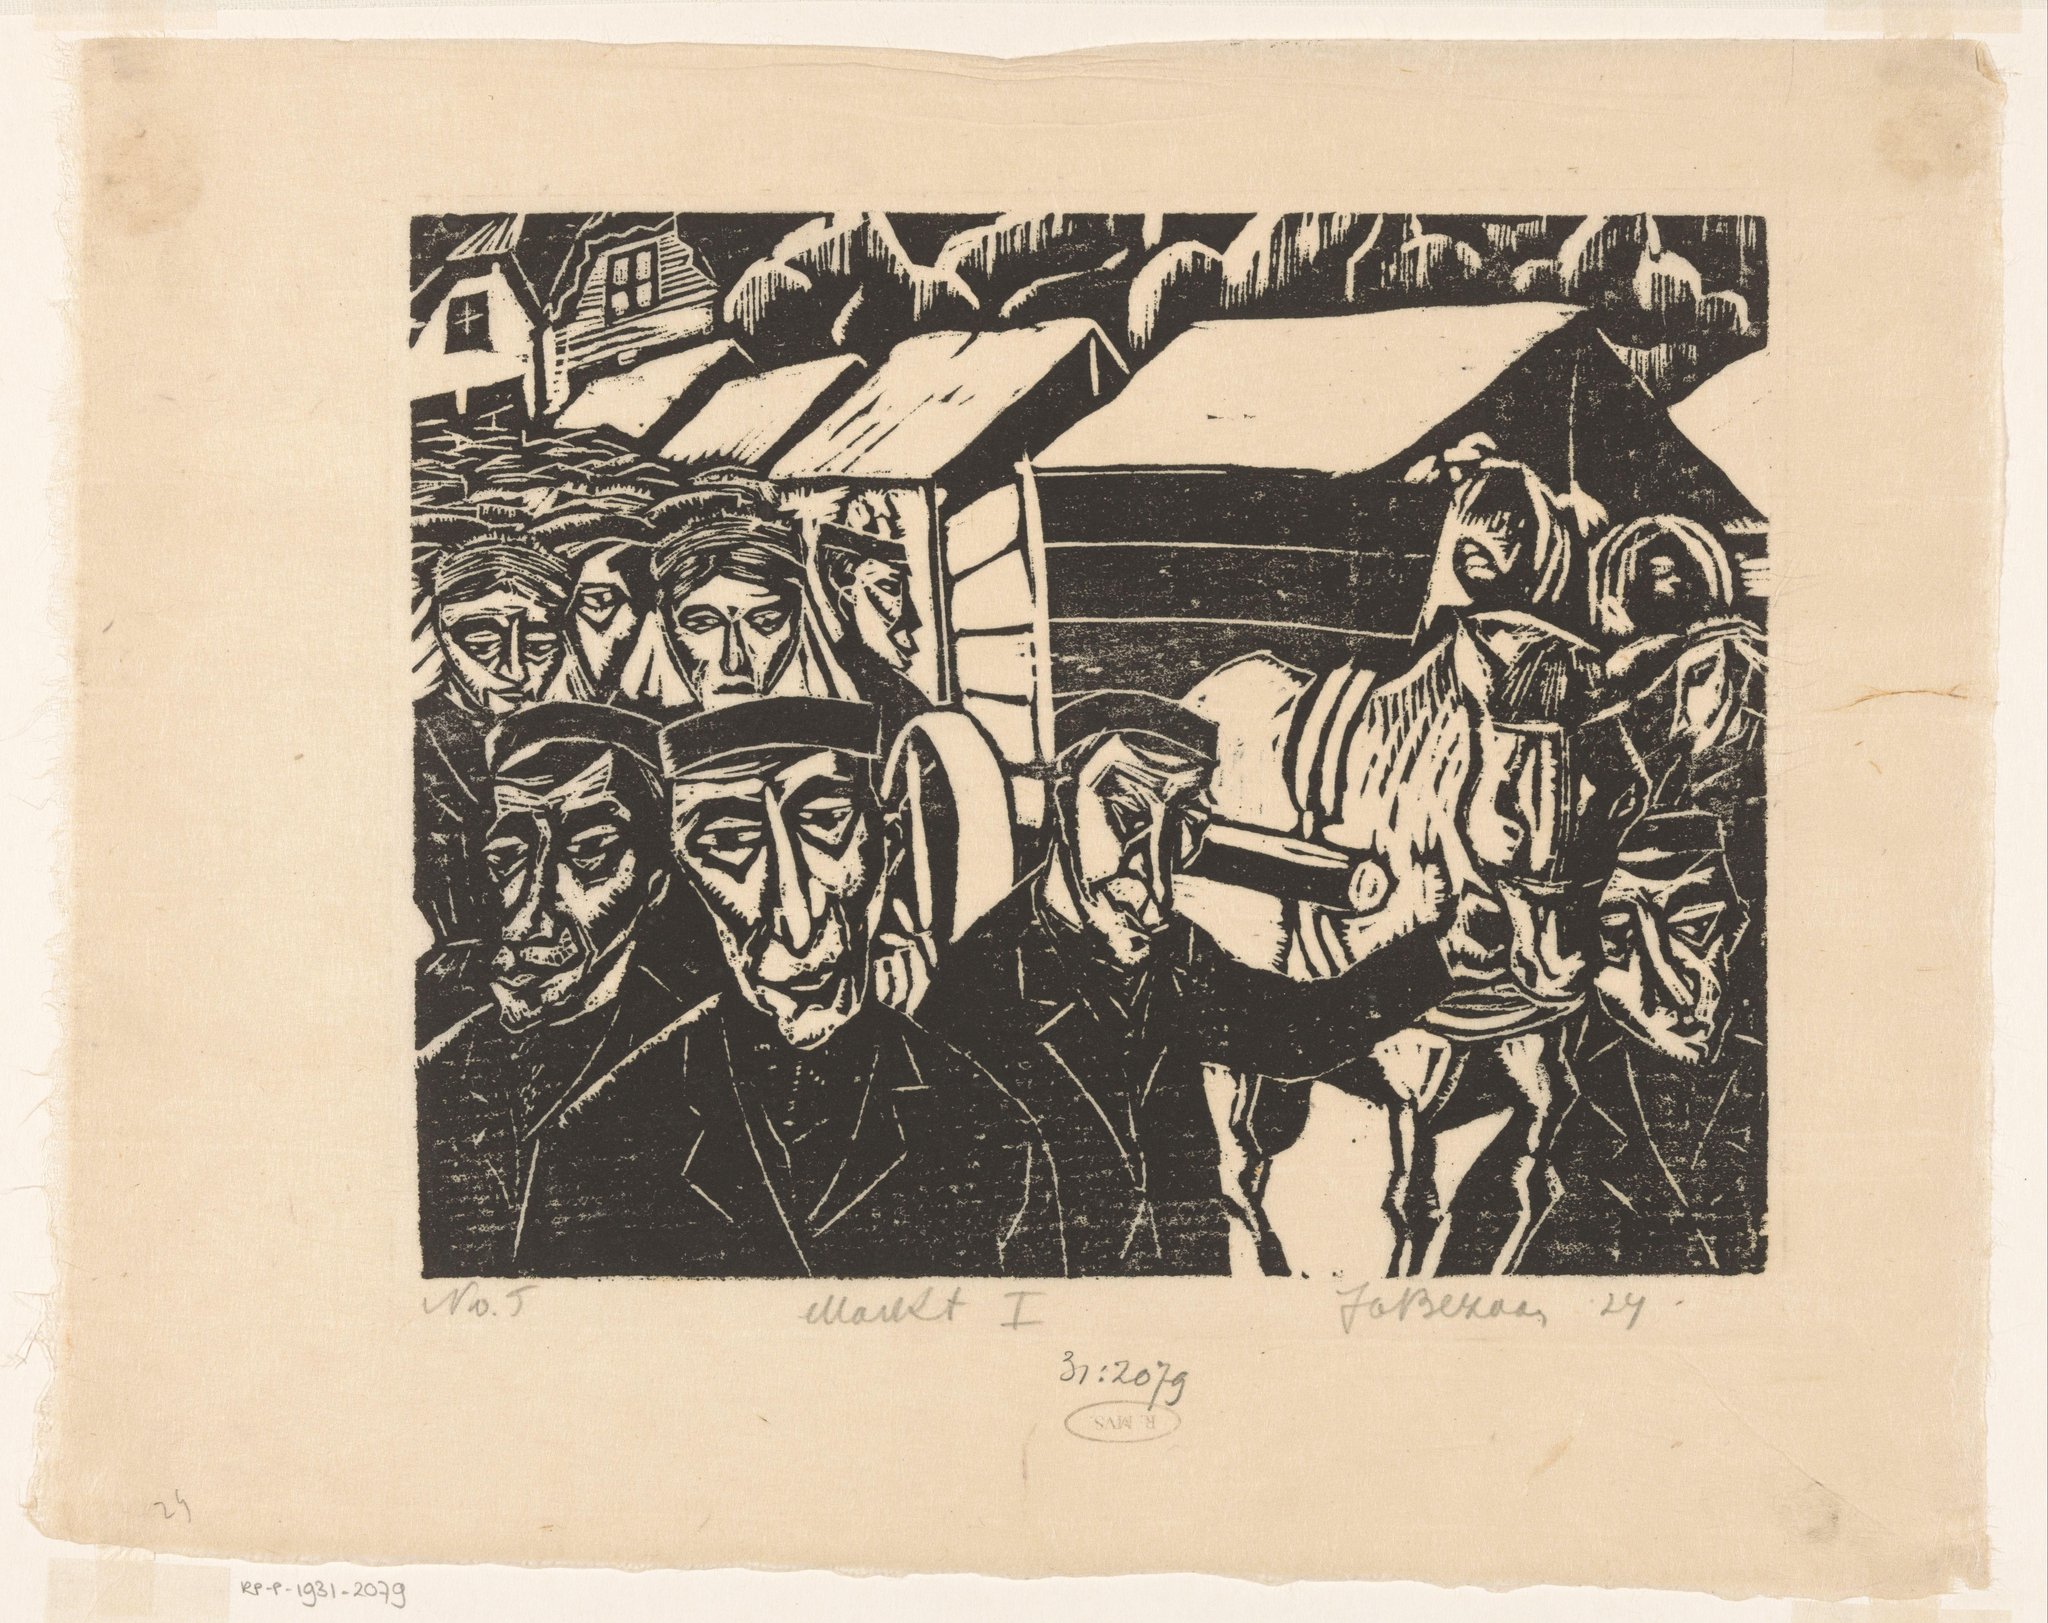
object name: print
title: Markt I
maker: jo bezaan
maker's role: draughtsman, print maker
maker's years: 1894-1952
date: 1924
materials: paper, ink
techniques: woodcut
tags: market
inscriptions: number: ‘No. 5’, signature and date: ‘JoBezaan 24’, title: ‘Markt I’, collector's mark: Lugt 2228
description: Stoet mensen met grove gezichten met rechts daarvan karren getrokken door een paard.